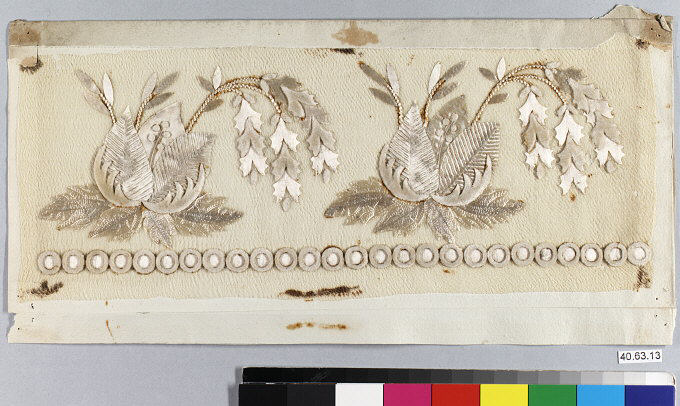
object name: border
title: Dress border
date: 1801-1833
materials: silk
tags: leaves